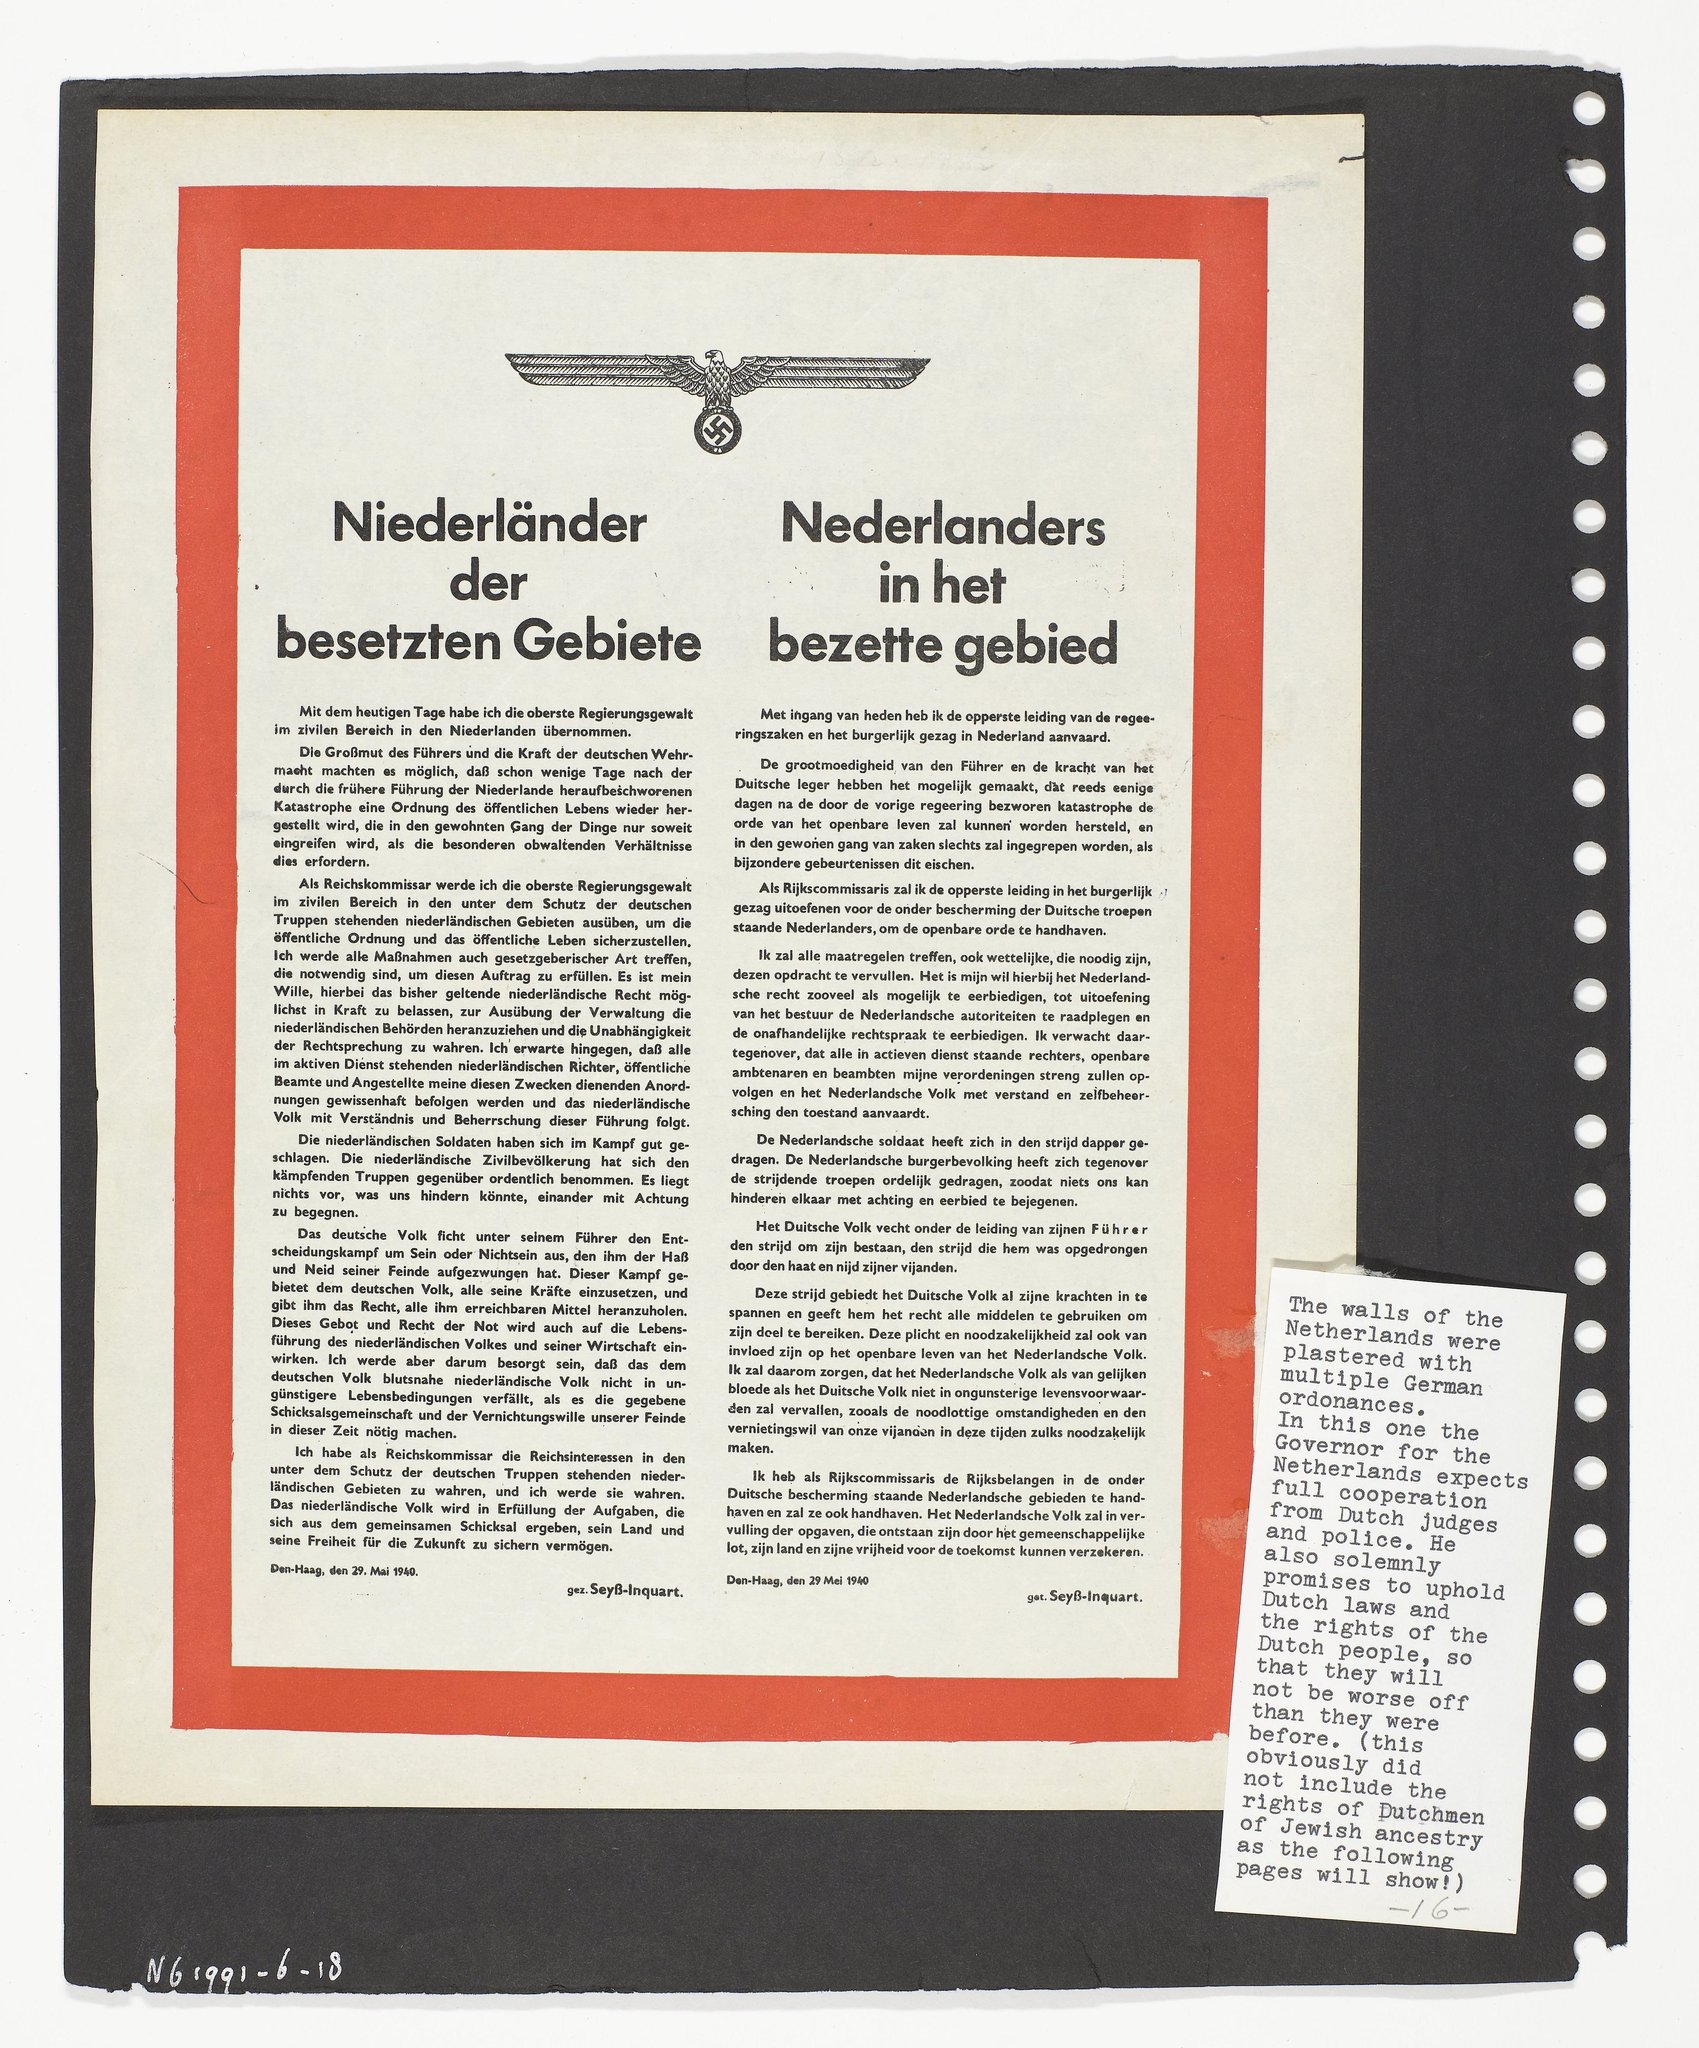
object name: poster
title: Foto en collageboek 'De Verborgen Camera'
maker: Anonymous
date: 1940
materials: paper, plastic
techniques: printing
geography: the hague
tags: amsterdam, tonny van renterghem, arthur seyss-inquart, berlin, fritz kahlenberg, underground movement, partisans, occupation ~ war, netherlands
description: Aanplakbiljet, tweetalig: Nederlanders in het bezette gebied. Ondertekend door Seyss Inquart